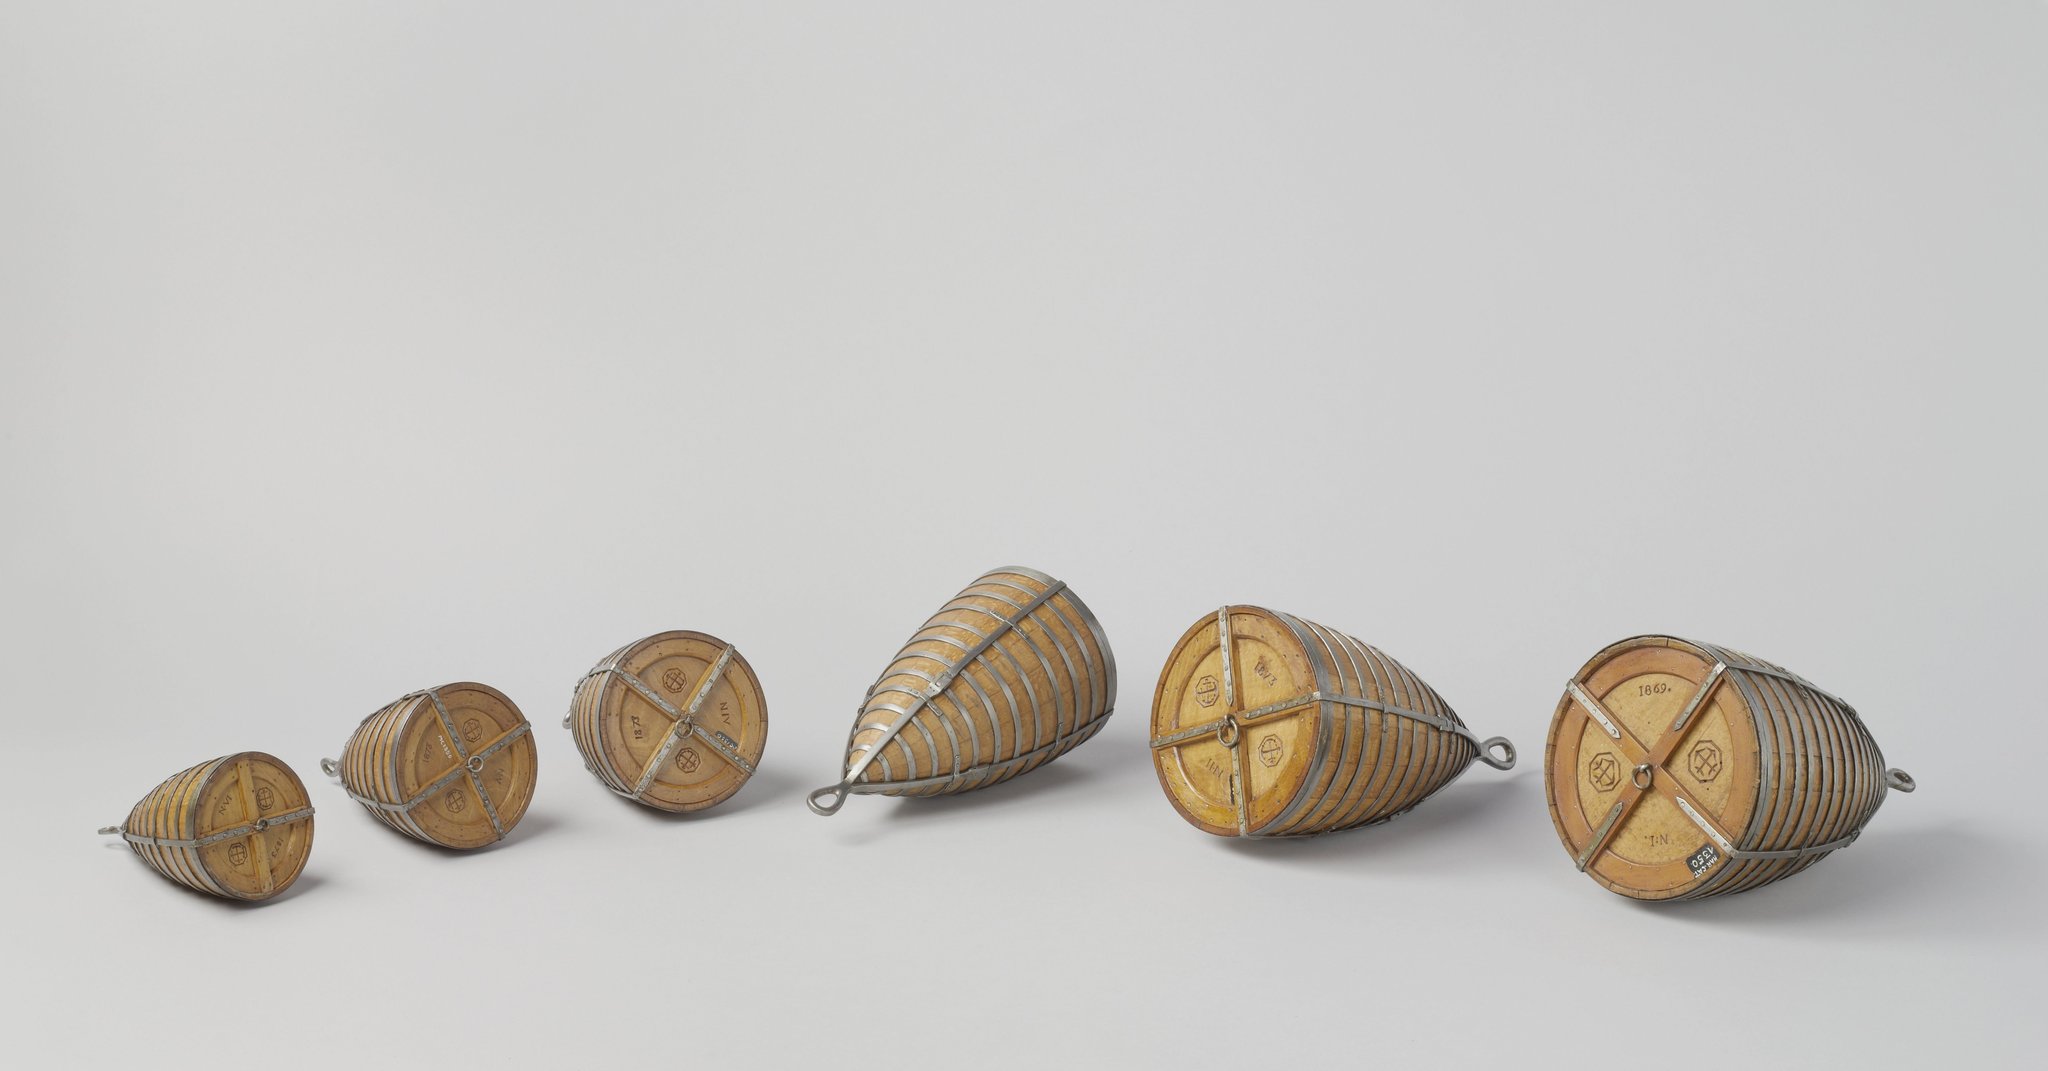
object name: demonstration model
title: Model of a Buoy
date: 1869-1873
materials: iron, wood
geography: enkhuizen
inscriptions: inscription: ‘N·VI / 1873’, monogram: crossed anchors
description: Model van een boei (buikton) met een conisch lichaam met een scherp uiteinde en een ronde platte bovenkant met een ring in het midden. Zoals een vat is zij samengesteld uit duigen en hoepels. Onderaan zit een oog voor de ankerketting. Gemerkt met gekruiste ankers. Model behoort bij serie van zes boeien van verschillende formaten. Schaal 1:10 (archief).